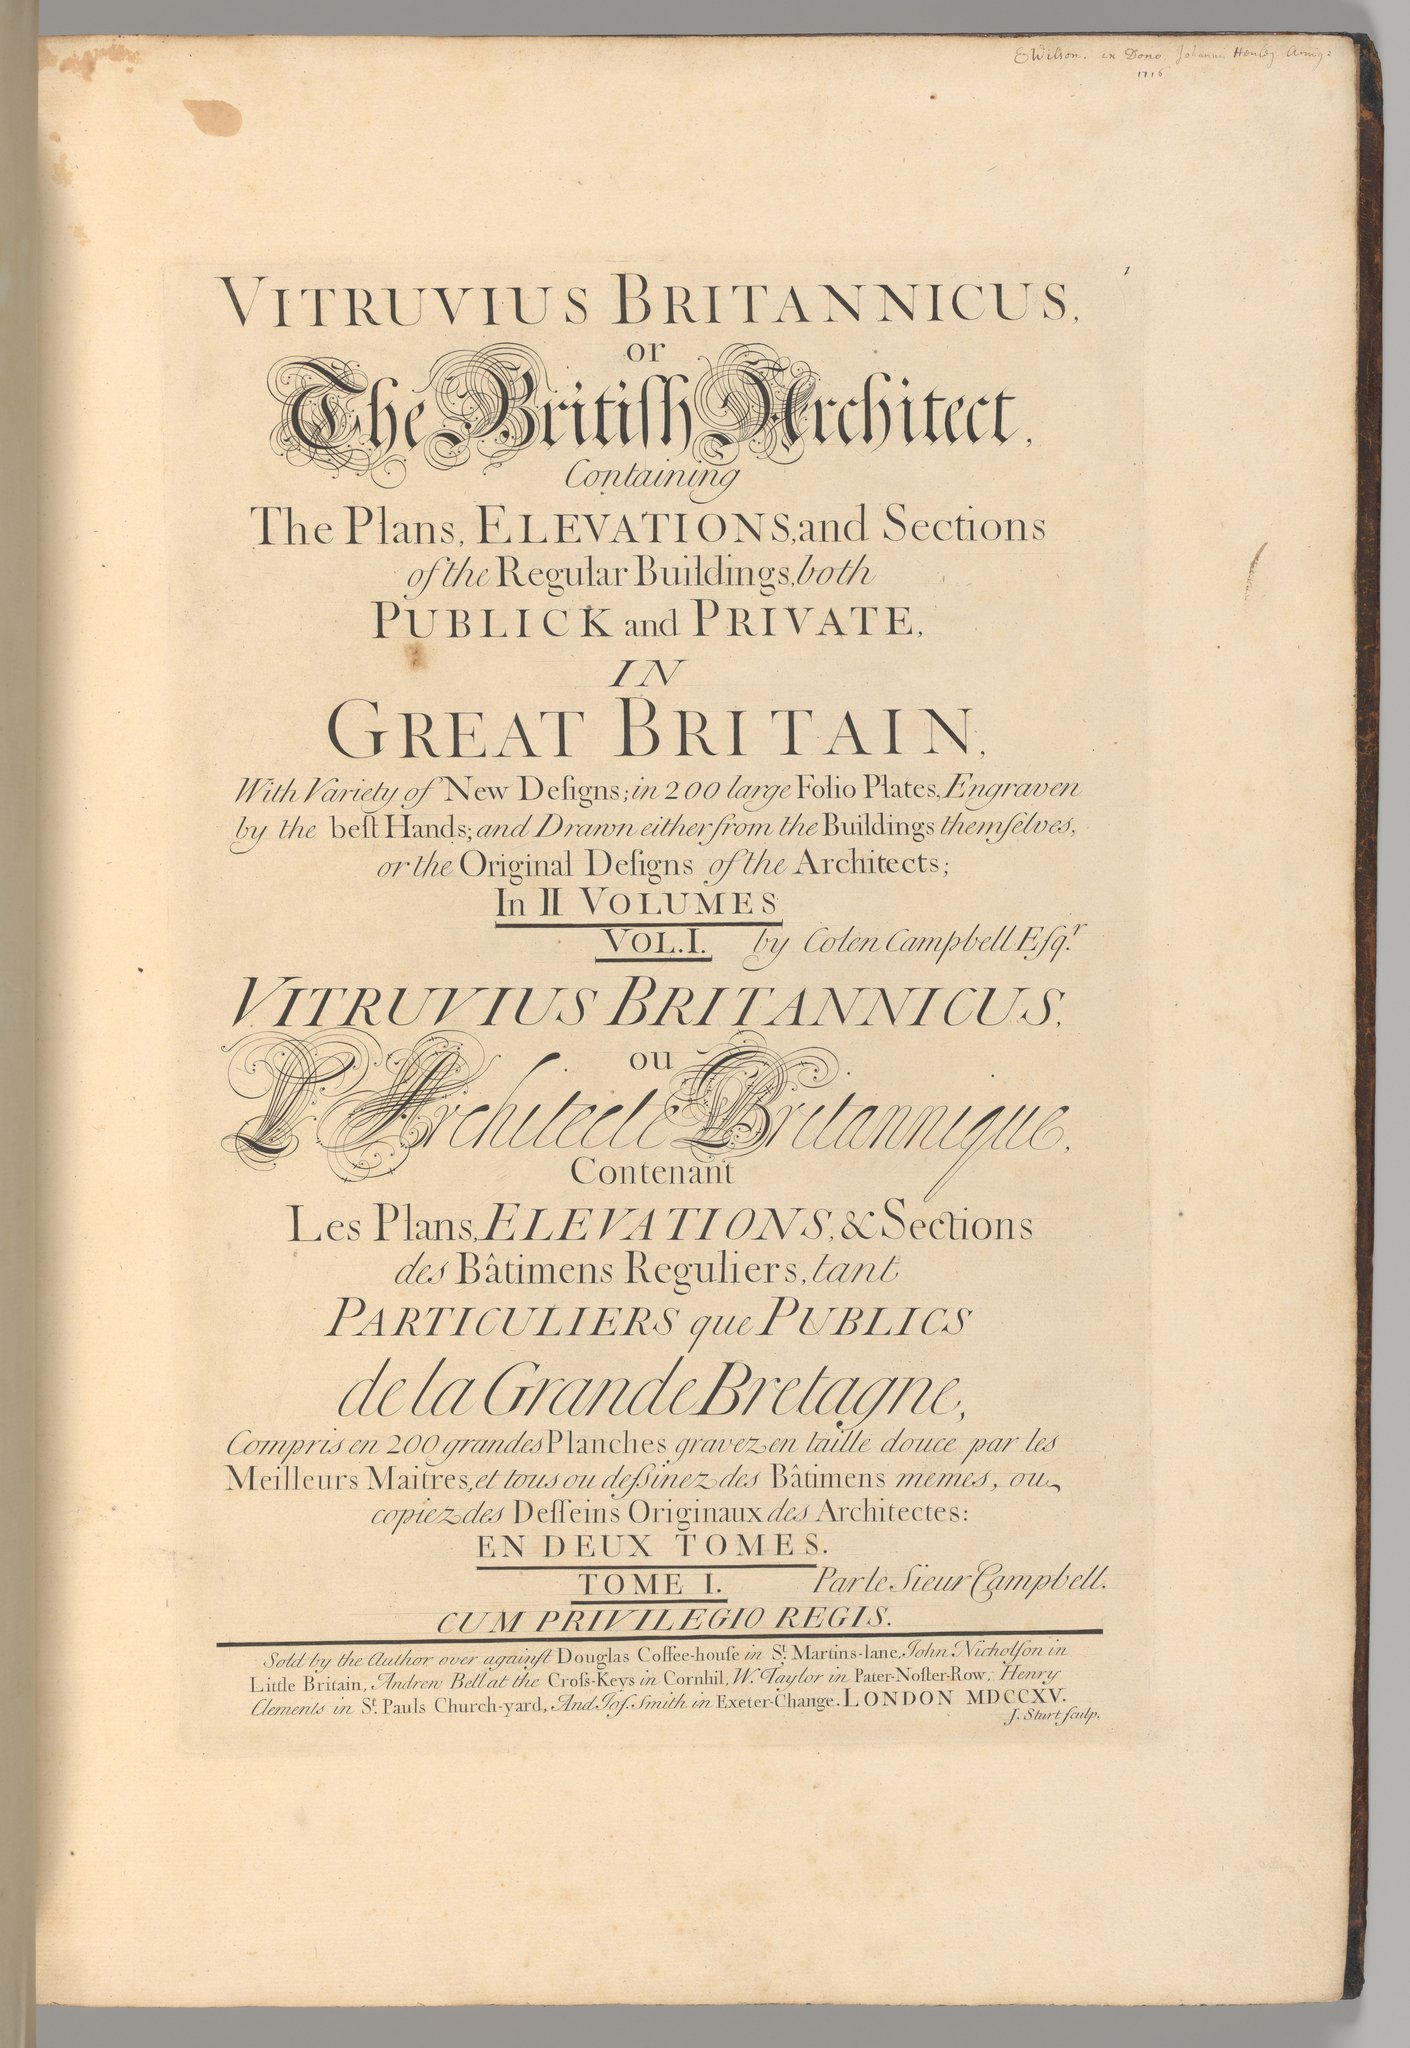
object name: book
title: Vitruvius Britannicus or The British Architect, The Plans, Elevations, and Sections of the Regular Buildings, both Publick and Private, in Great Britain,...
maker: colen campbell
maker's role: author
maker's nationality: british, scottish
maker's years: 1676-1729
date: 1715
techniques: engraving, etching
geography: england